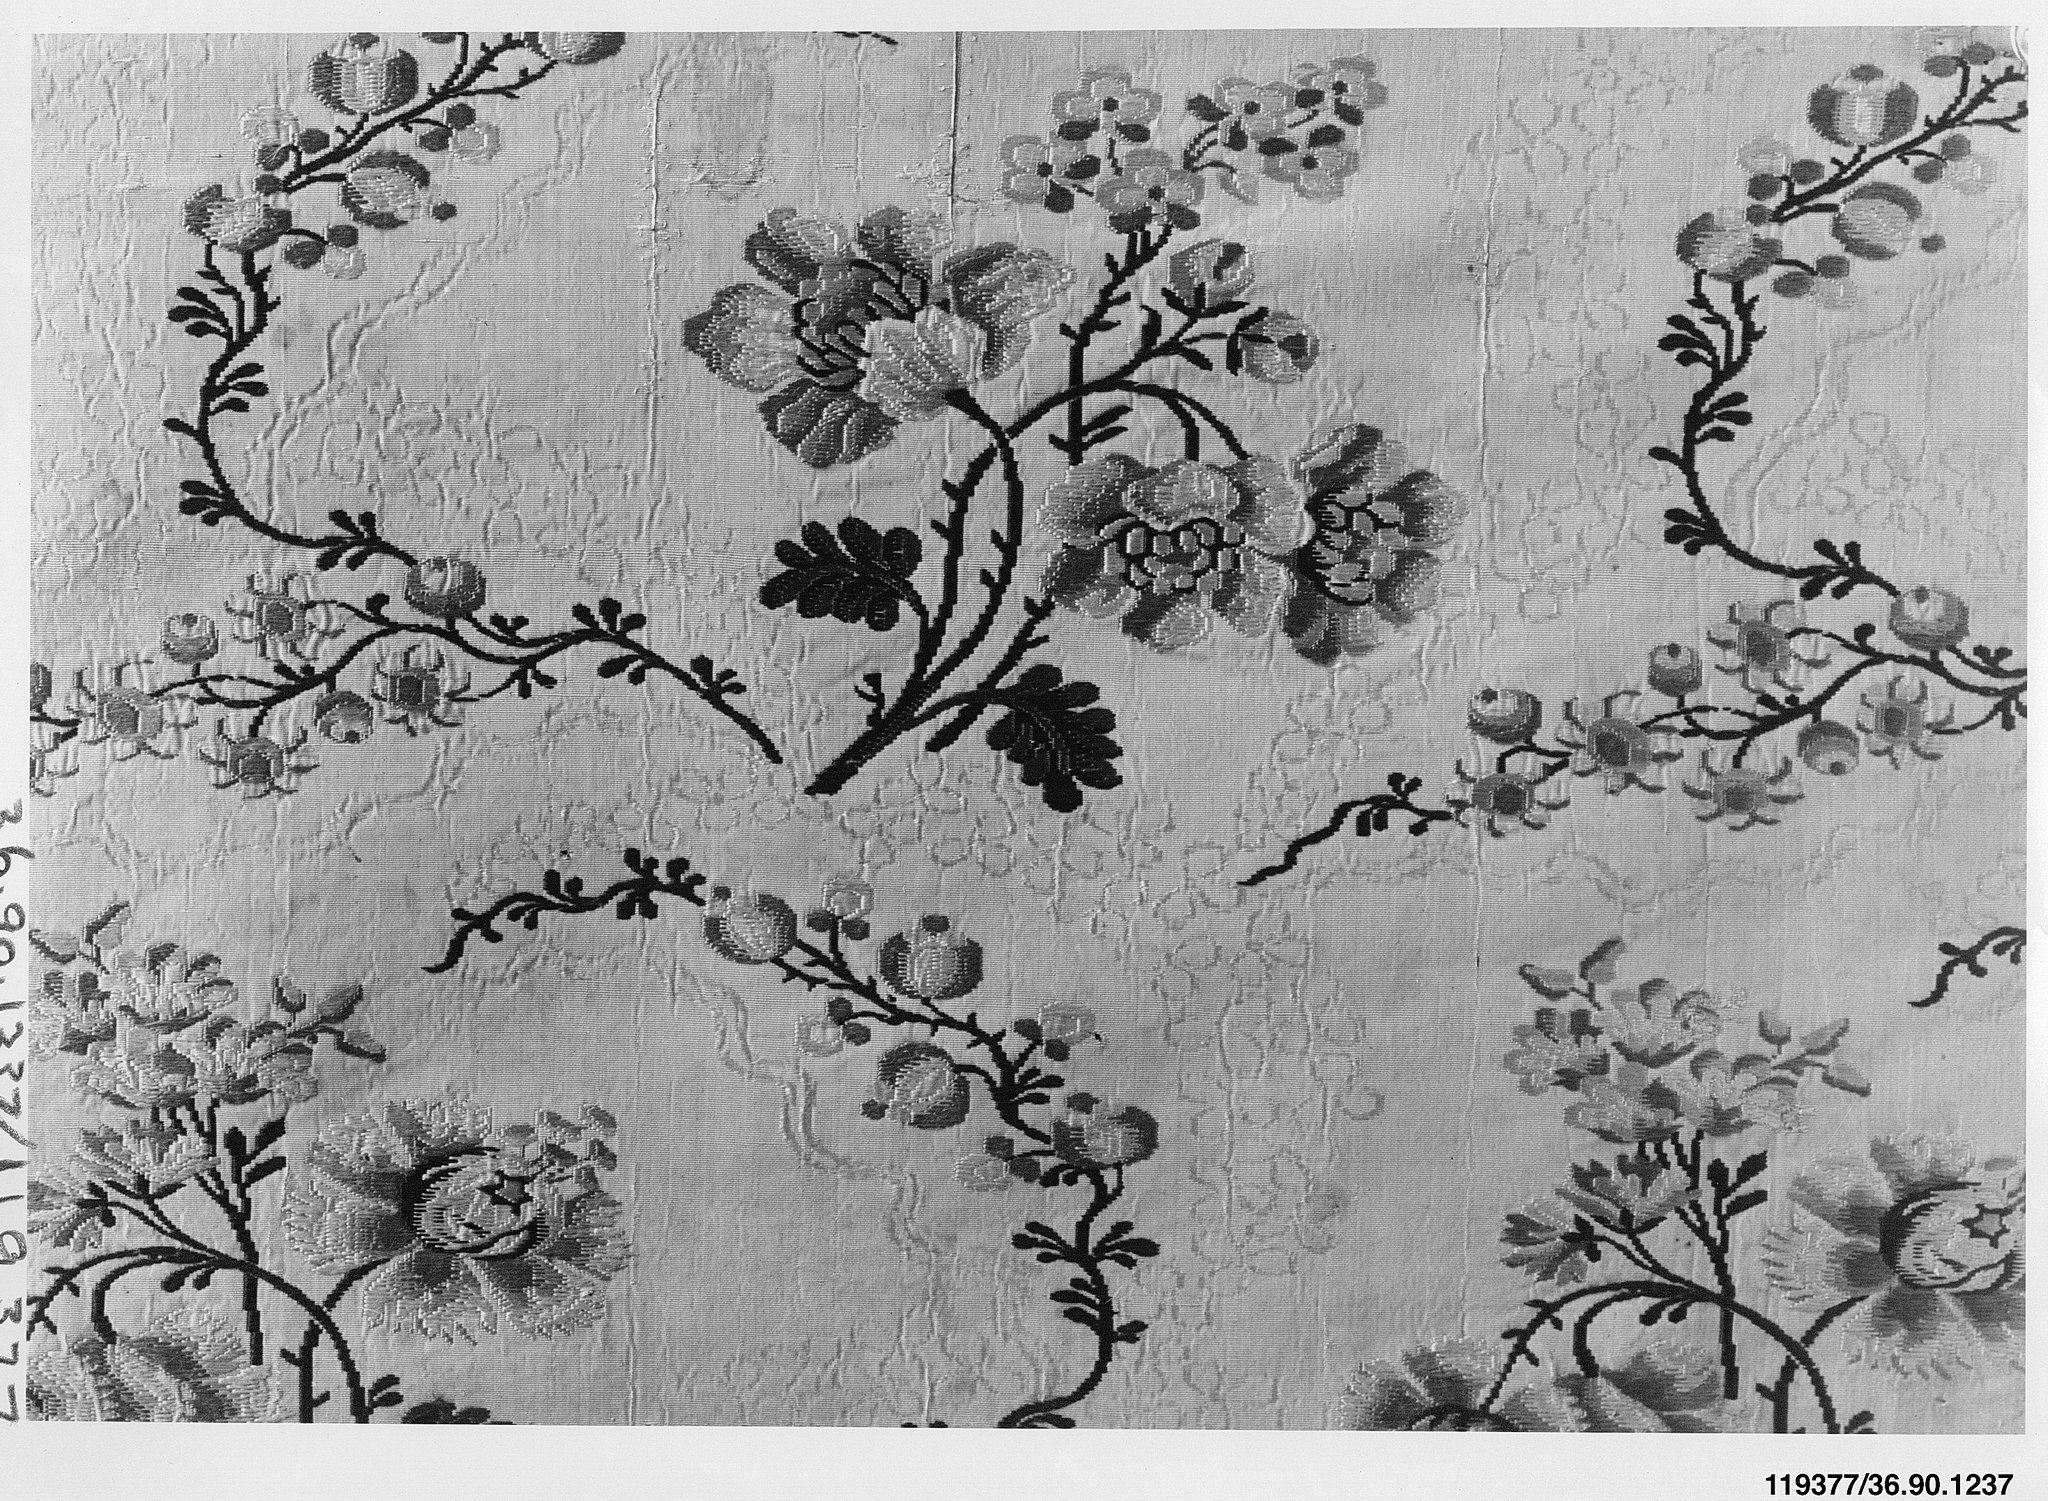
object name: piece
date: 1750-1760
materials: silk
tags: flowers,leaves